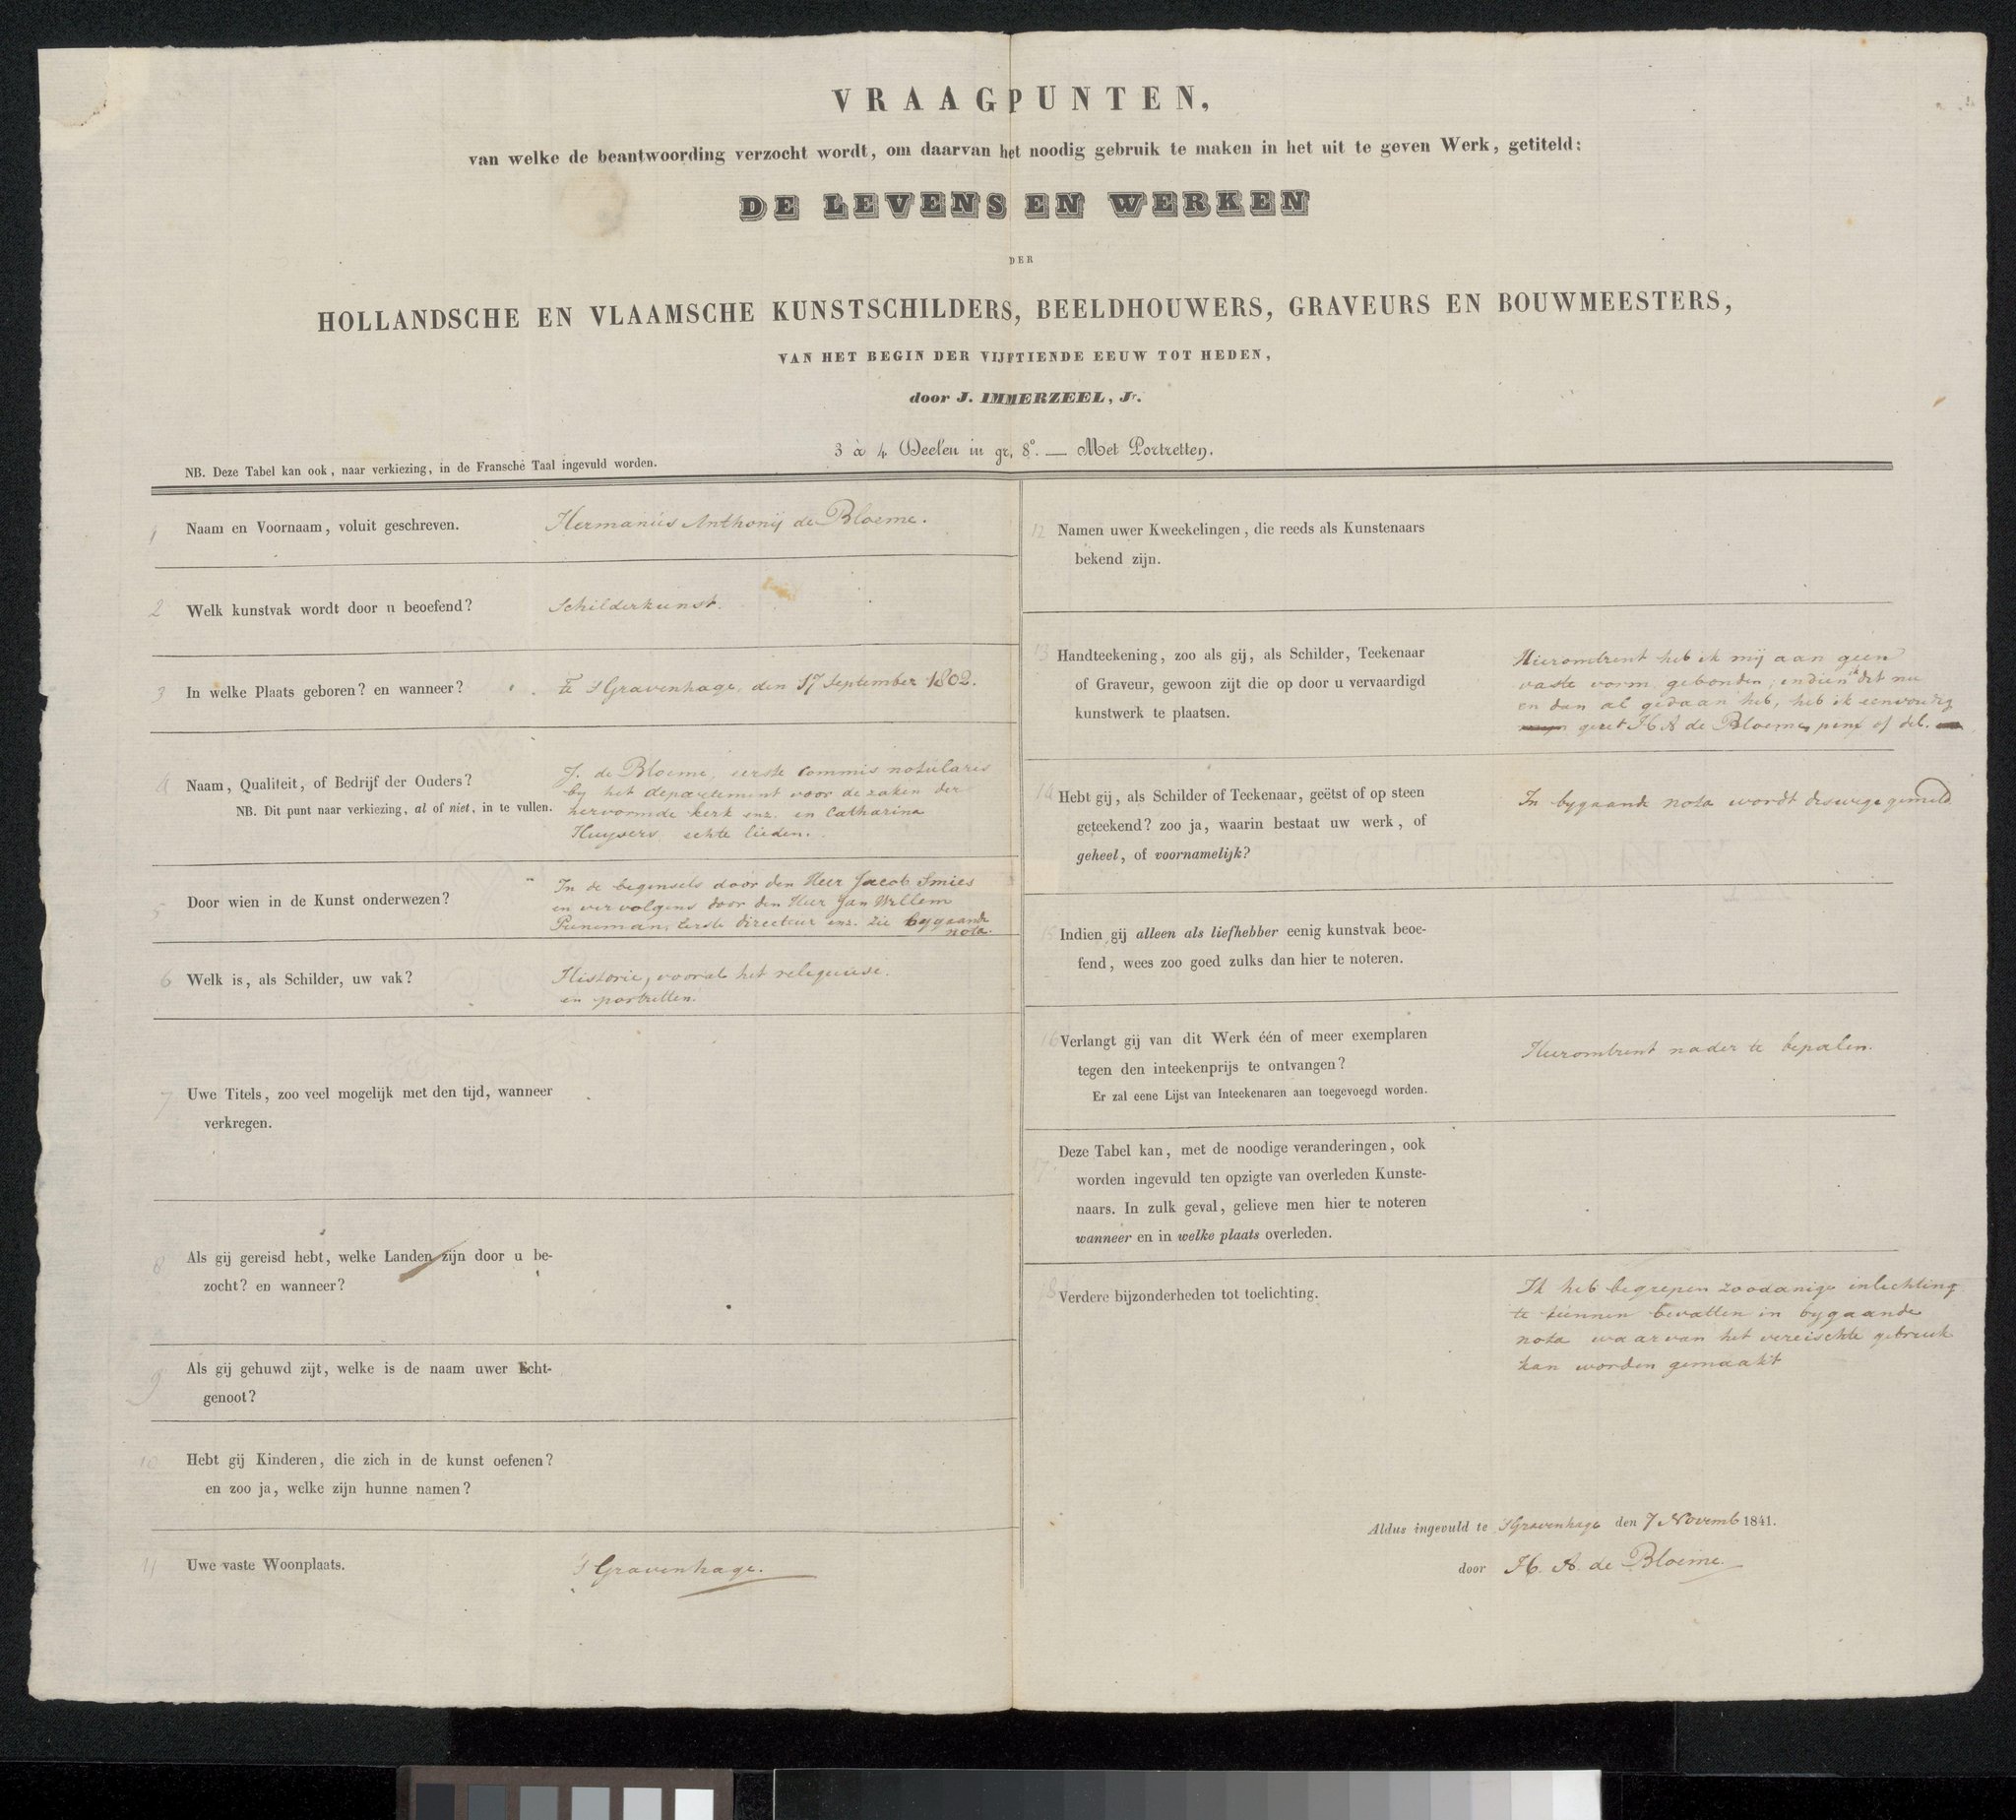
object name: questionnaire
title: Enquêteformulier ingevuld door Herman Antoine de Bloeme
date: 1841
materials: ink, paper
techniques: pen, printing, writing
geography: the hague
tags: painter, herman antonie de bloeme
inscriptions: watermark, inscription: ‘Vraagpunten,/ van welke de beantwoording verzocht wordt, om daarvan het noodig gebruik te maken in het uit te geven Werk, getiteld: De levens en werken/ der Hollandsche en Vlaamsche kunstschilders, beeldhouwers,/ graveurs en bouwmeesters, van het begin der vijftiende eeuw tot heden/ door J. Immerzeel, Jr.’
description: Opgenomen in: Immerzeel, J. Jr., De levens en werken der Hollandsche en Vlaamsche kunstschilders, beeldhouwers, graveurs en bouwmeesters, van het begin der vijftiende eeuw tot heden, Amsterdam: J.C. van Kesteren, 1842-1843.